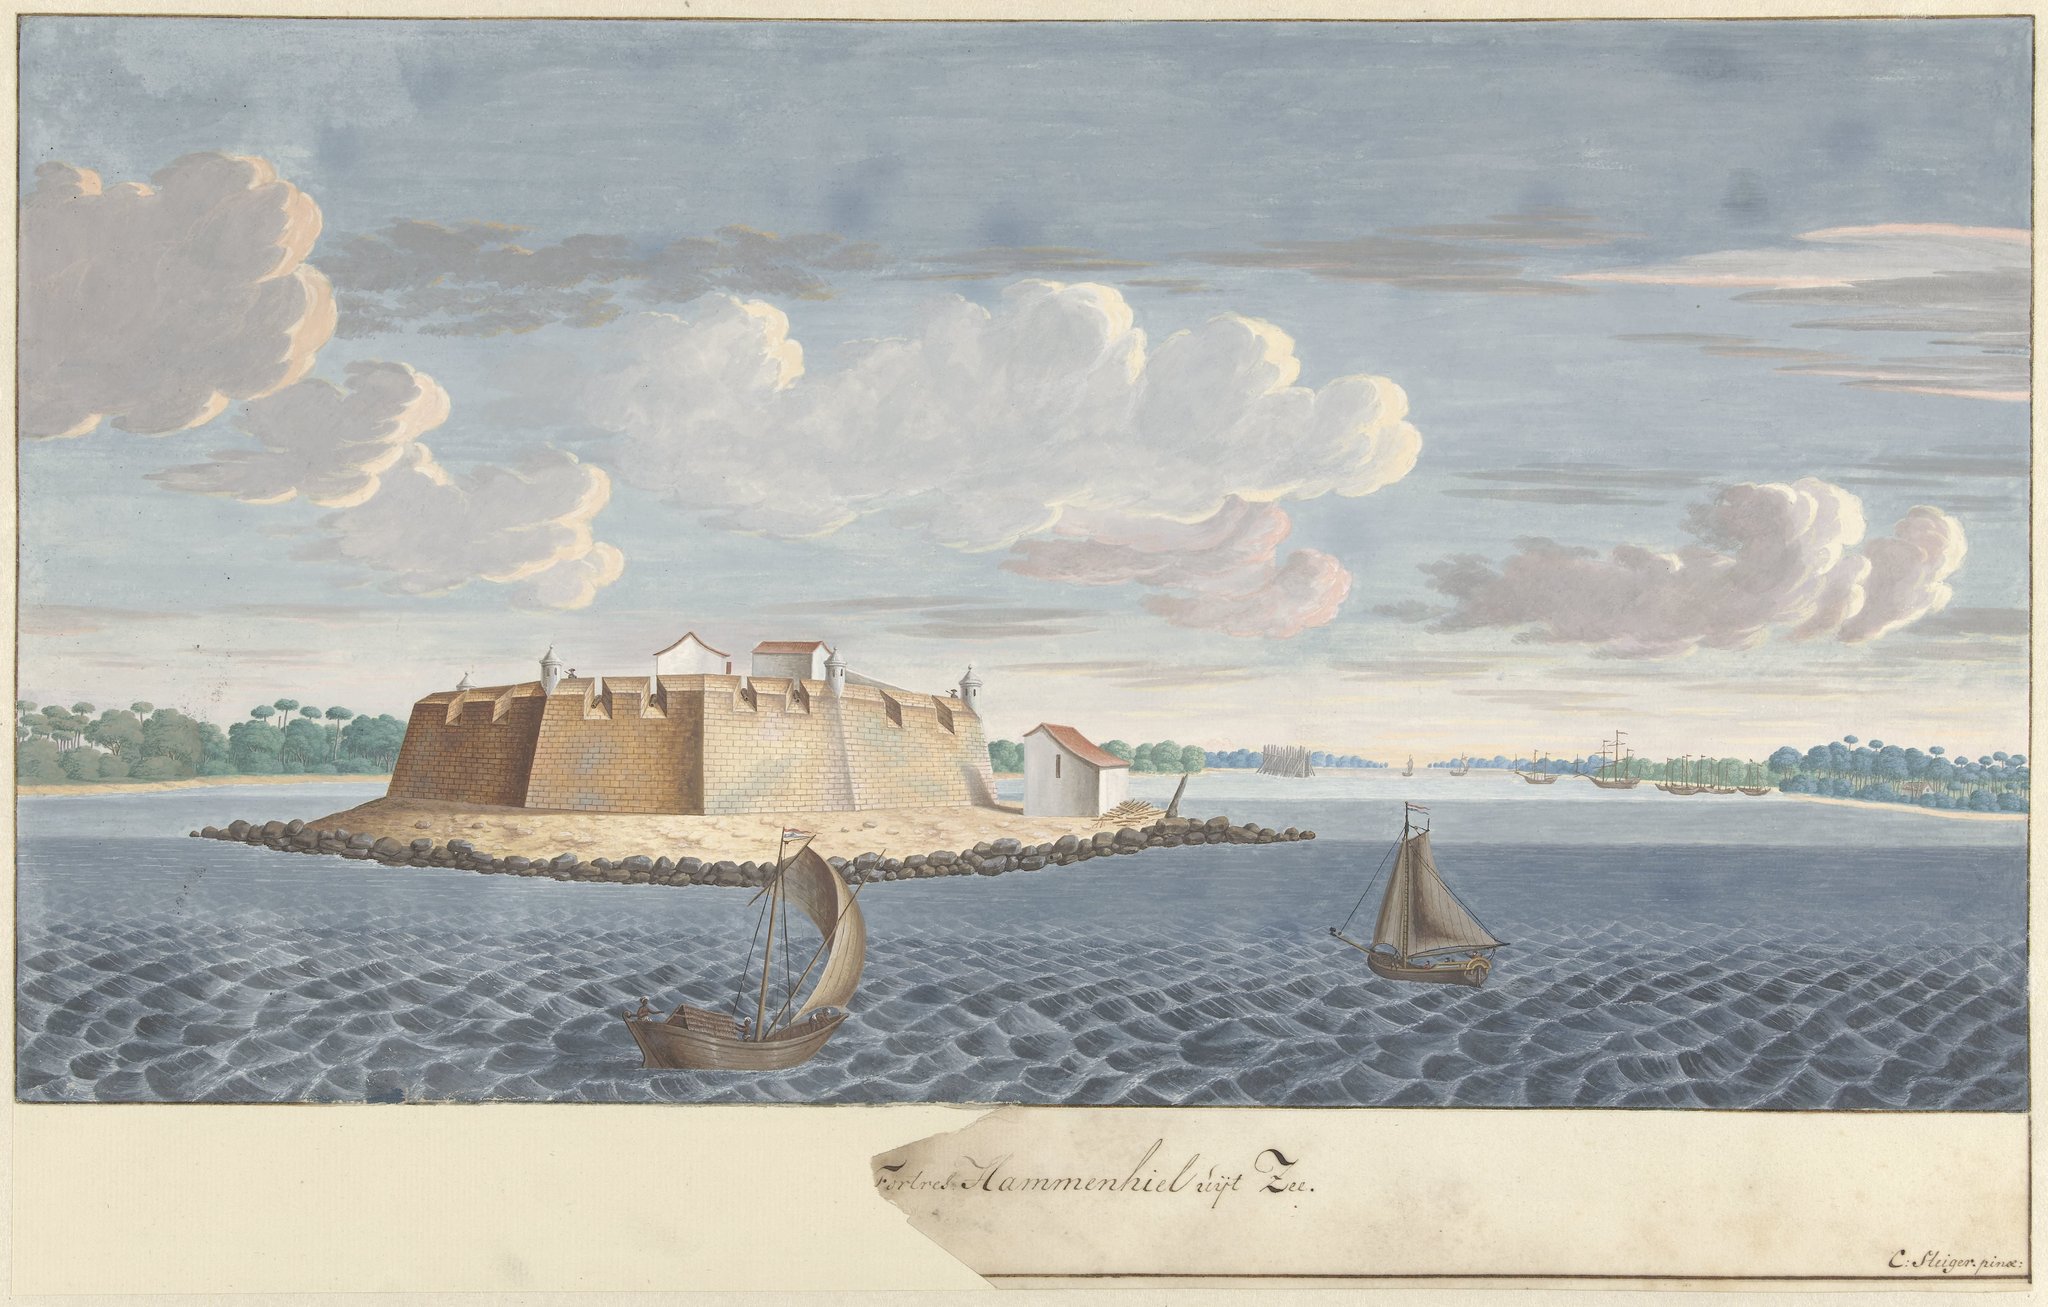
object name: drawing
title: Fort Hammenhiel (Hummenil) te Ceylon, gezien van zee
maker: cornelis steiger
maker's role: draughtsman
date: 1710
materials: paint, paper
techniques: brush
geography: sri lanka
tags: fortress, sri lanka